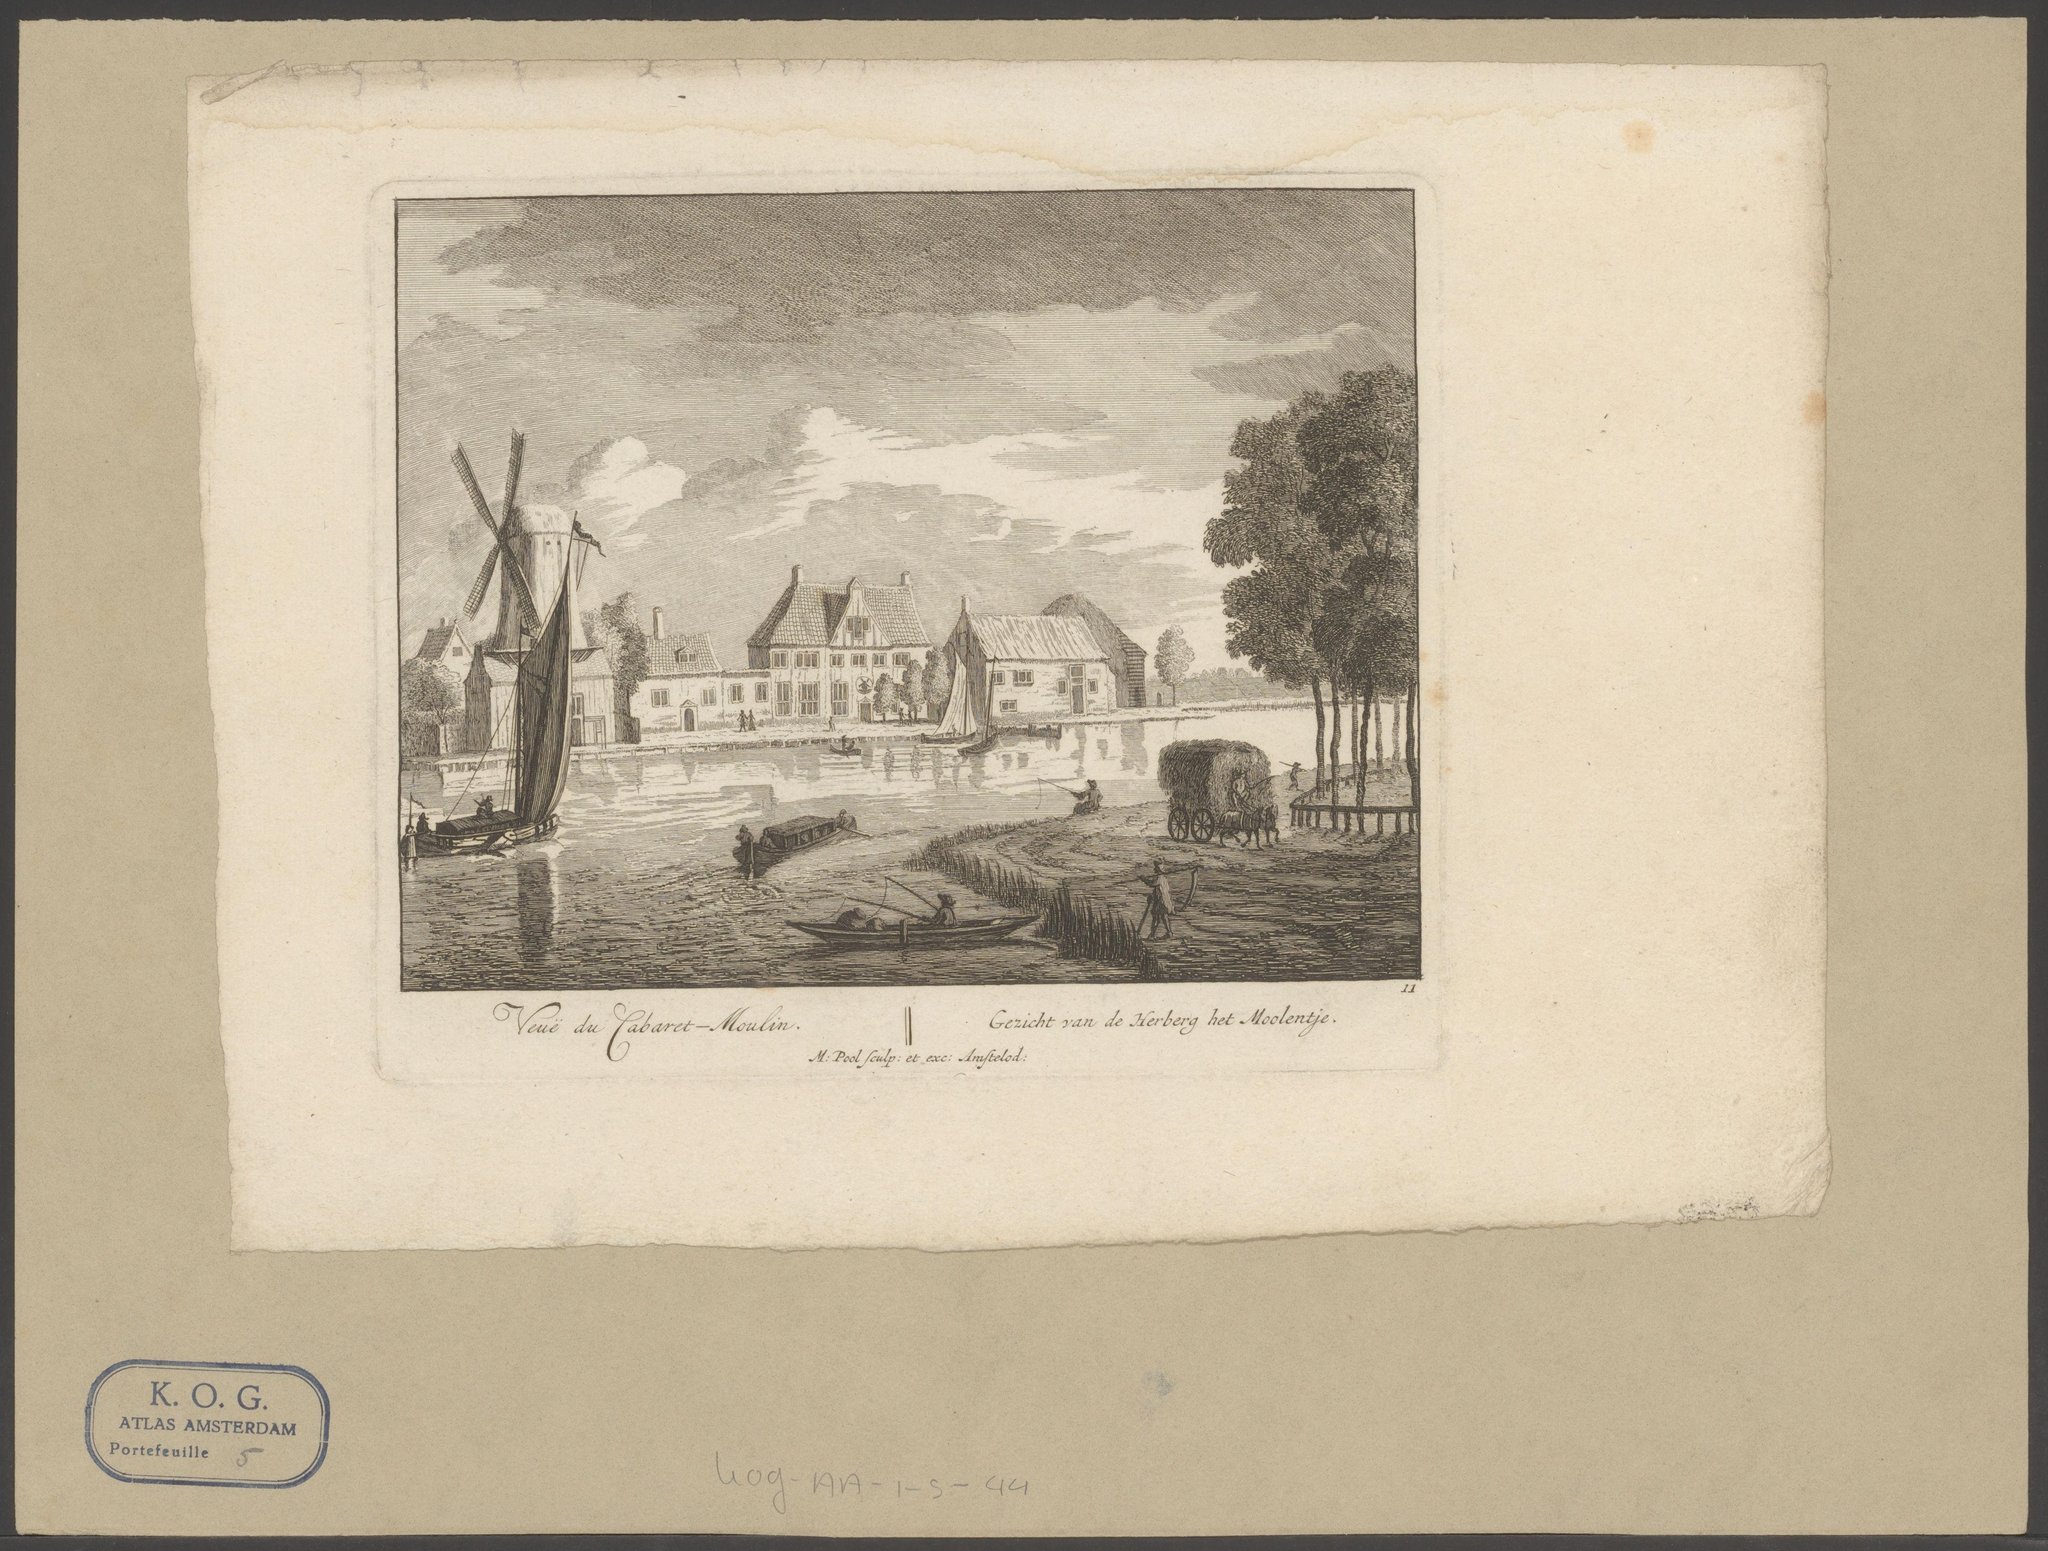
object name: print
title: Gezicht op de Amstel bij herberg het Moolentje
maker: matthijs pool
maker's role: print maker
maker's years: 1676-1740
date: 1708-1740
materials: paper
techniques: etching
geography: amsterdam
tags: sailing-ship, sailing-boat, city-view in general; 'veduta', river, windmill in landscape, boat propelled by man or animal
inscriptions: collector's mark: ‘5’ Lugt 1641b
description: Prent waarschijnlijk uit: Pool, Matthijs. Verscheyde gesigten van de vermaarde rievier de buyten Amstel van de stadt Amsterdam, tot het dorp Ouwerkerk (…) / Plusieurs veuës et perspectives de la fameuse riviére de Buyten-Amstel depuis Amsterdam jusqu'au village d'Ouwerkerk (…). Amsterdam: Matthijs Pool, z.j. [1708-1740].